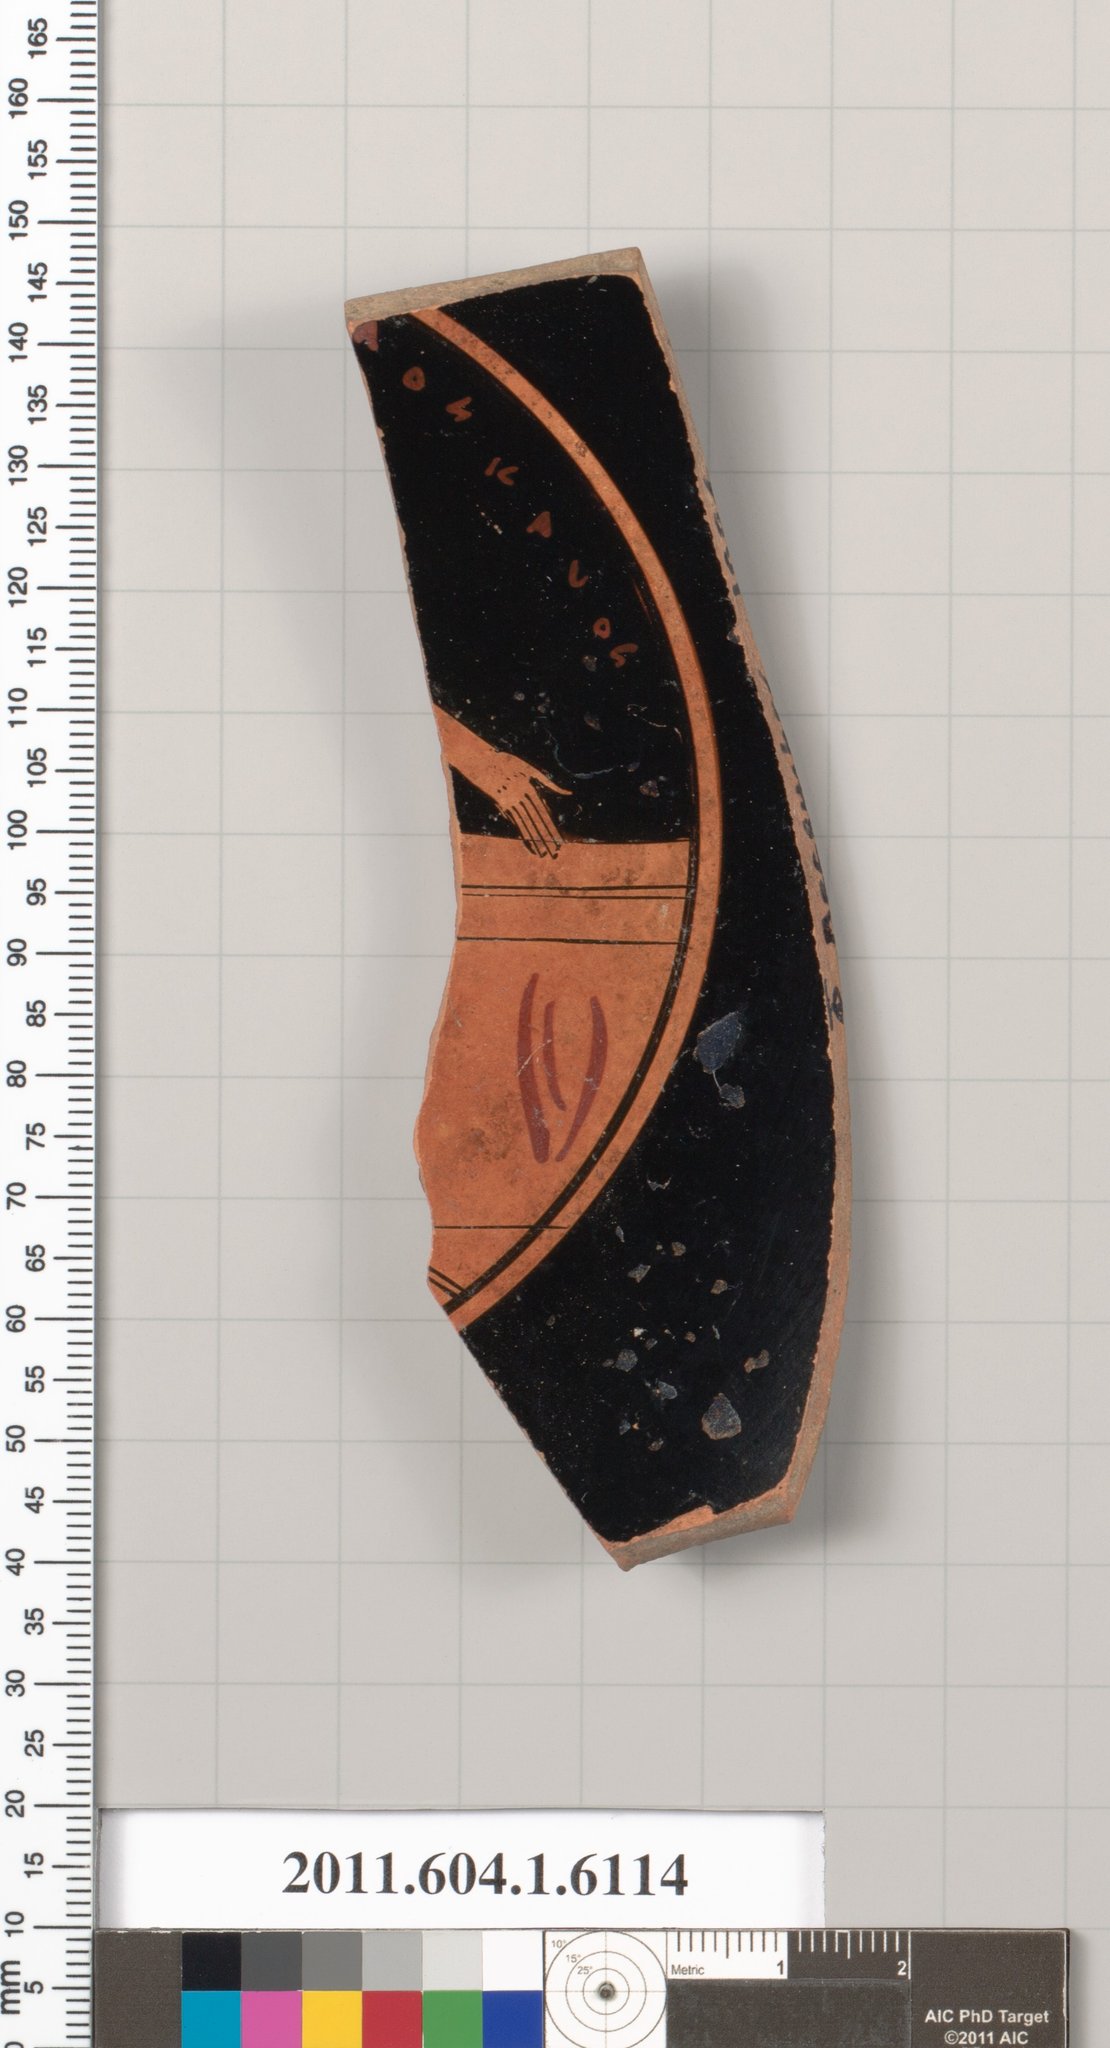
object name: kylix fragment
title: Terracotta fragment of a kylix (drinking cup)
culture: greek, attic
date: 510-490 BCE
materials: terracotta